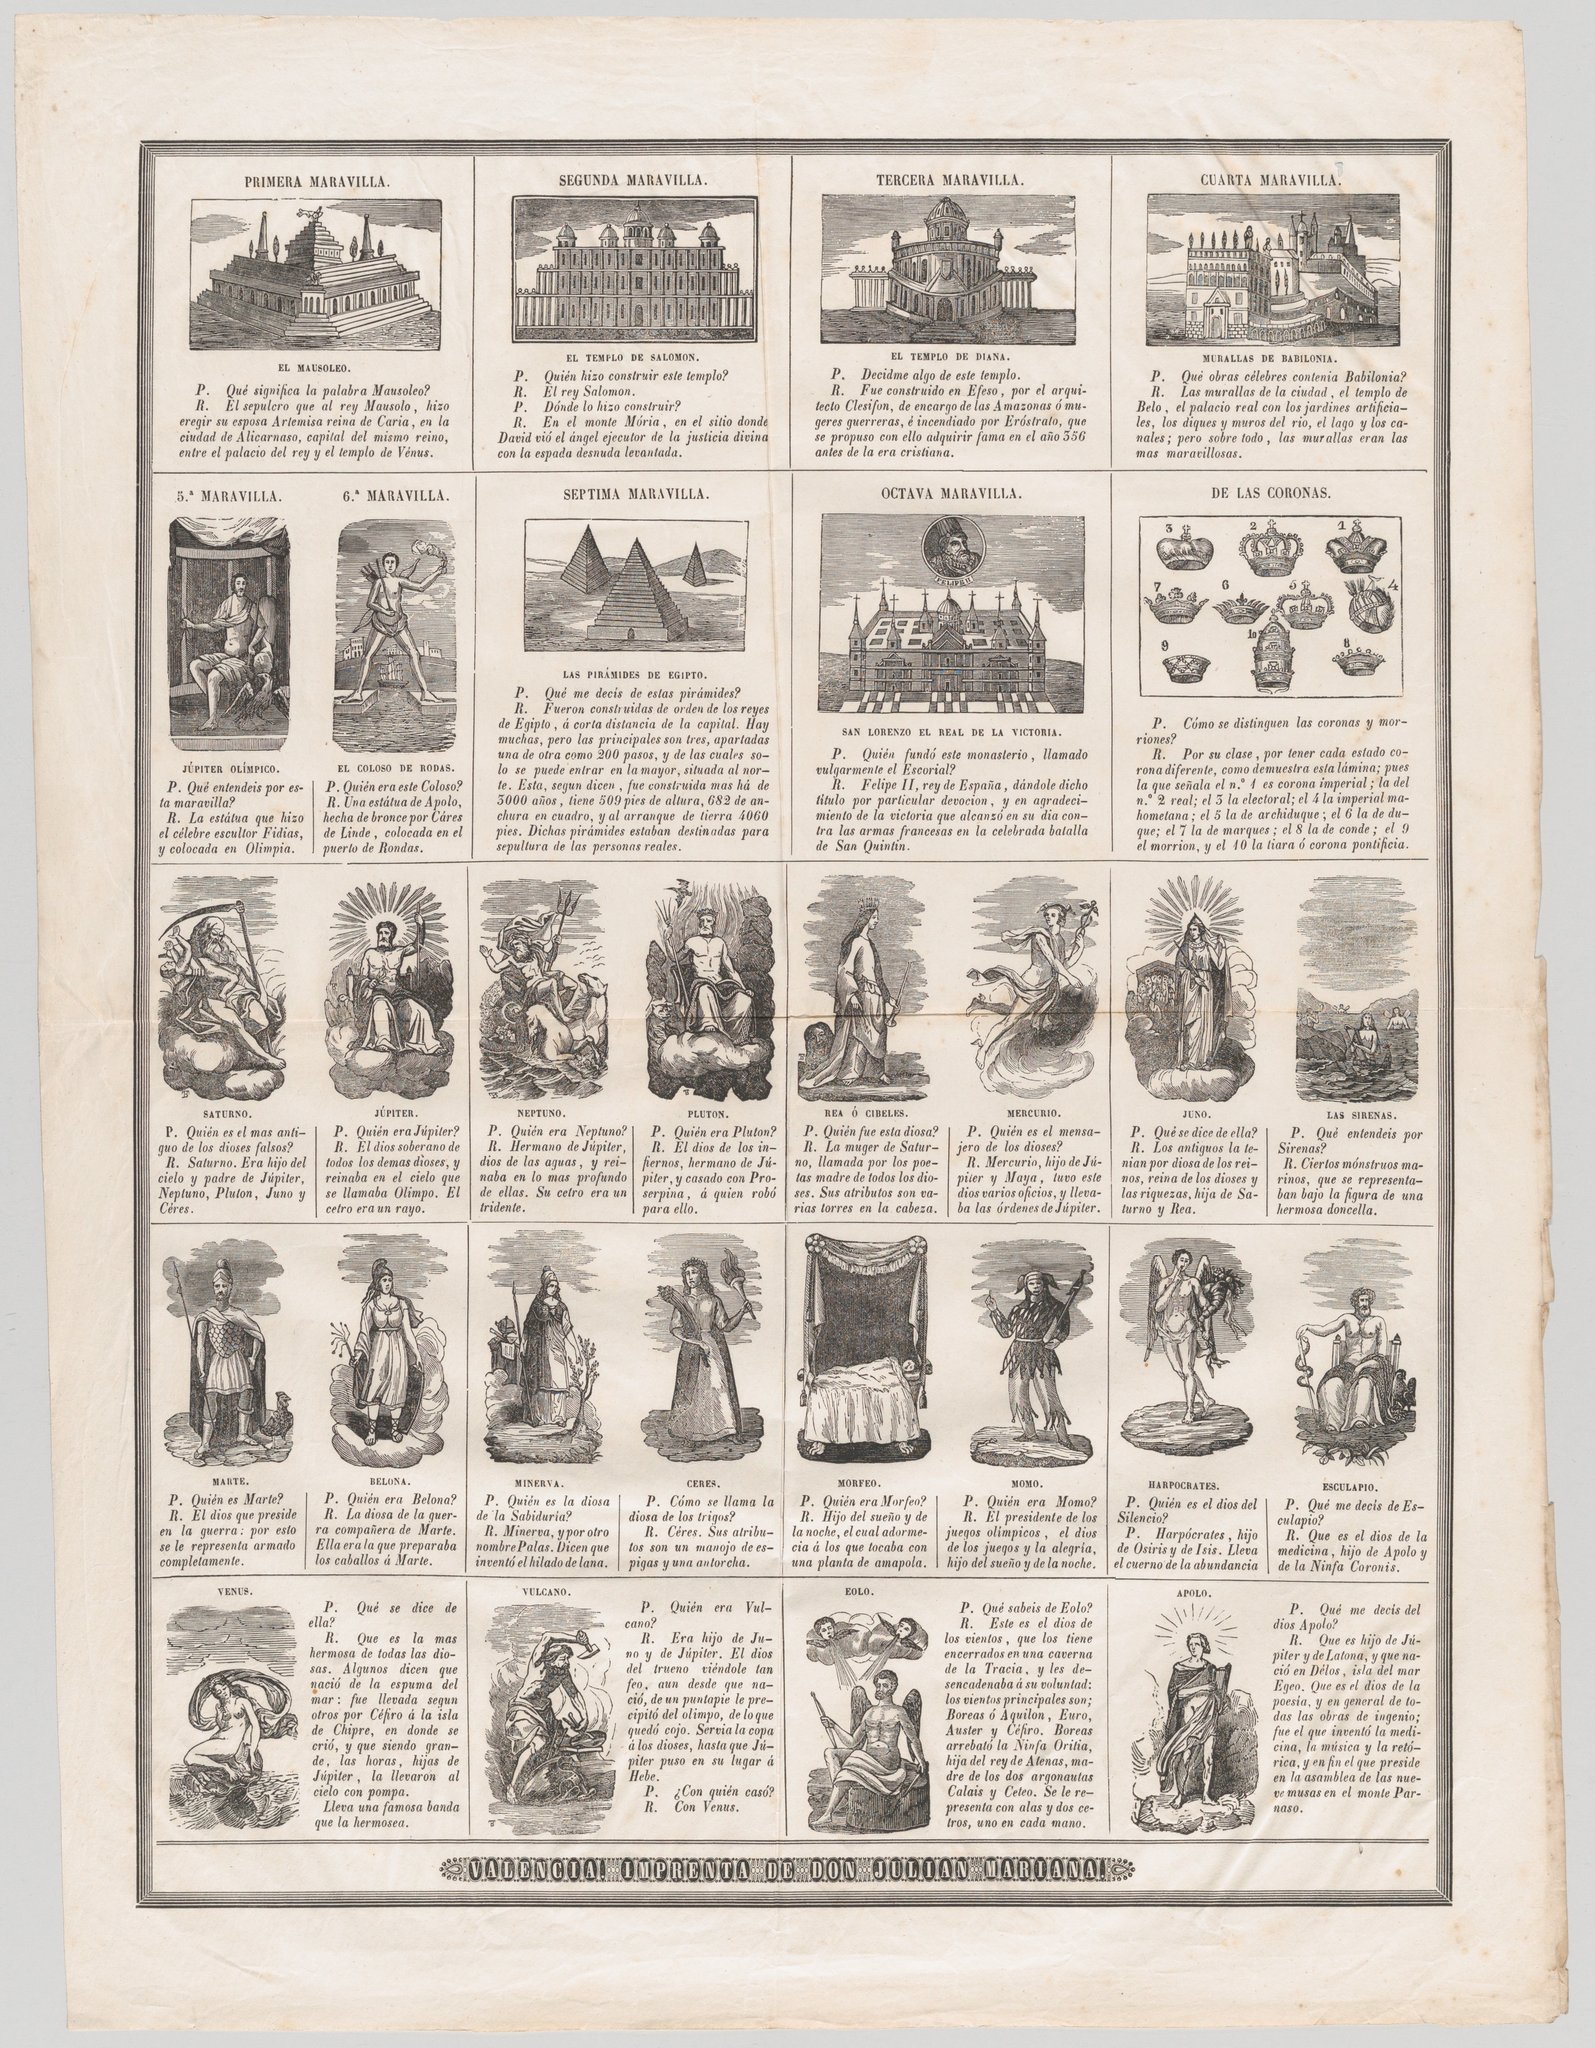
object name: print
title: Eight wonders of the world and mythical Gods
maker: julian mariana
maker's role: publisher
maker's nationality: spanish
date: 1860-1870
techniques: letterpress, engraving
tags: buildings,gods